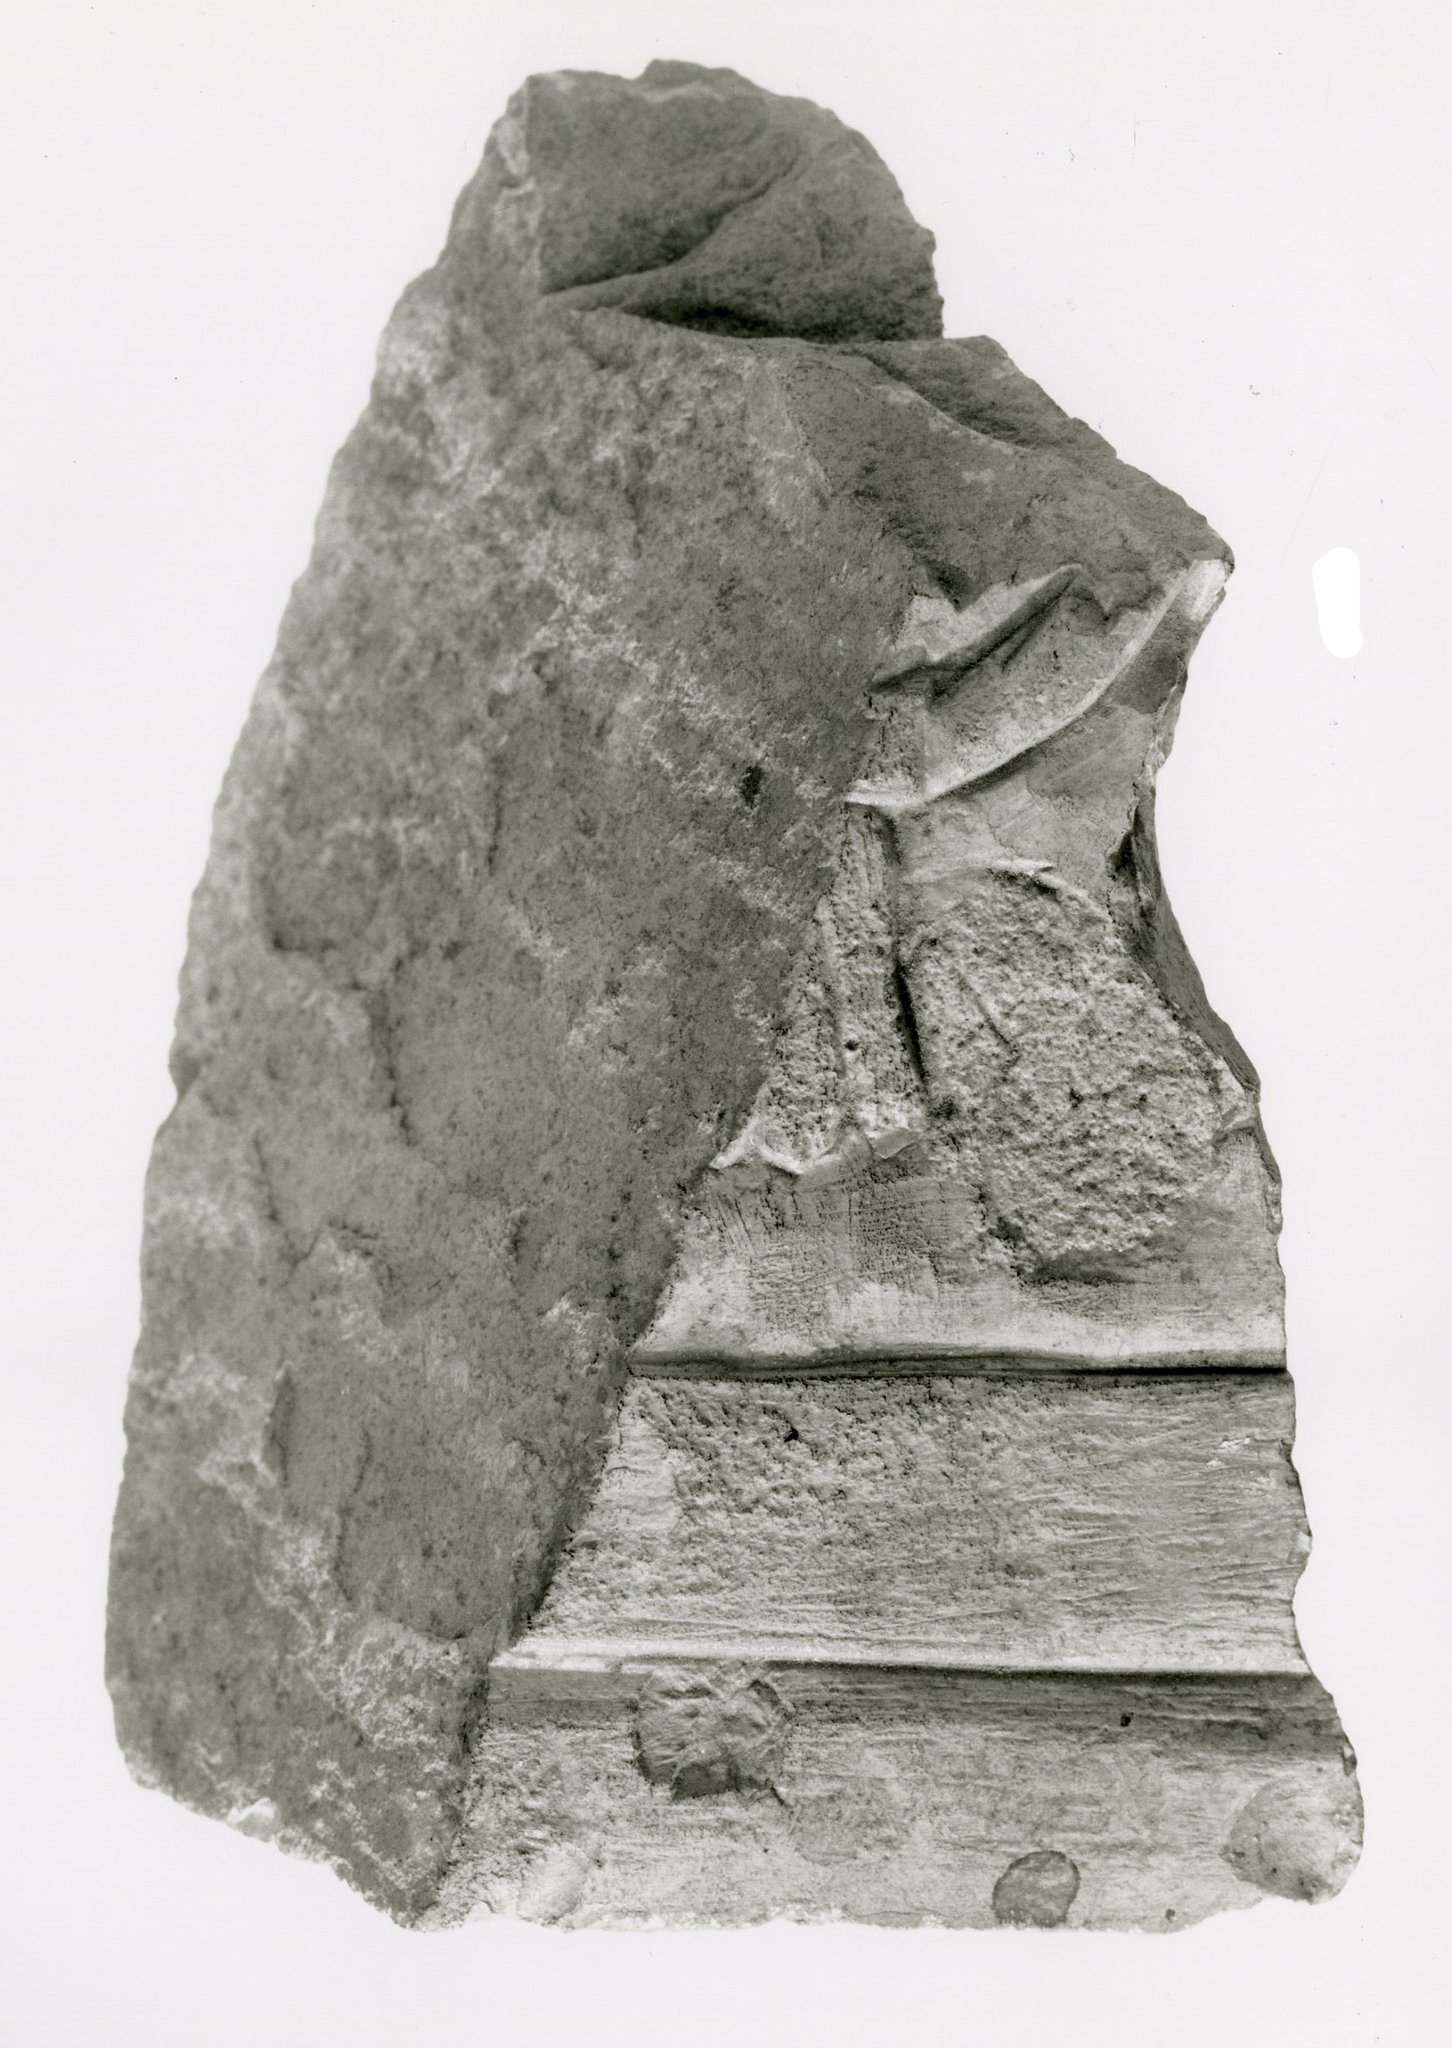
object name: relief, tomb of nespekashuty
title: Raised Relief Fragment with Slaughtering Scene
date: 664-610 BCE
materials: limestone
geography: egypt